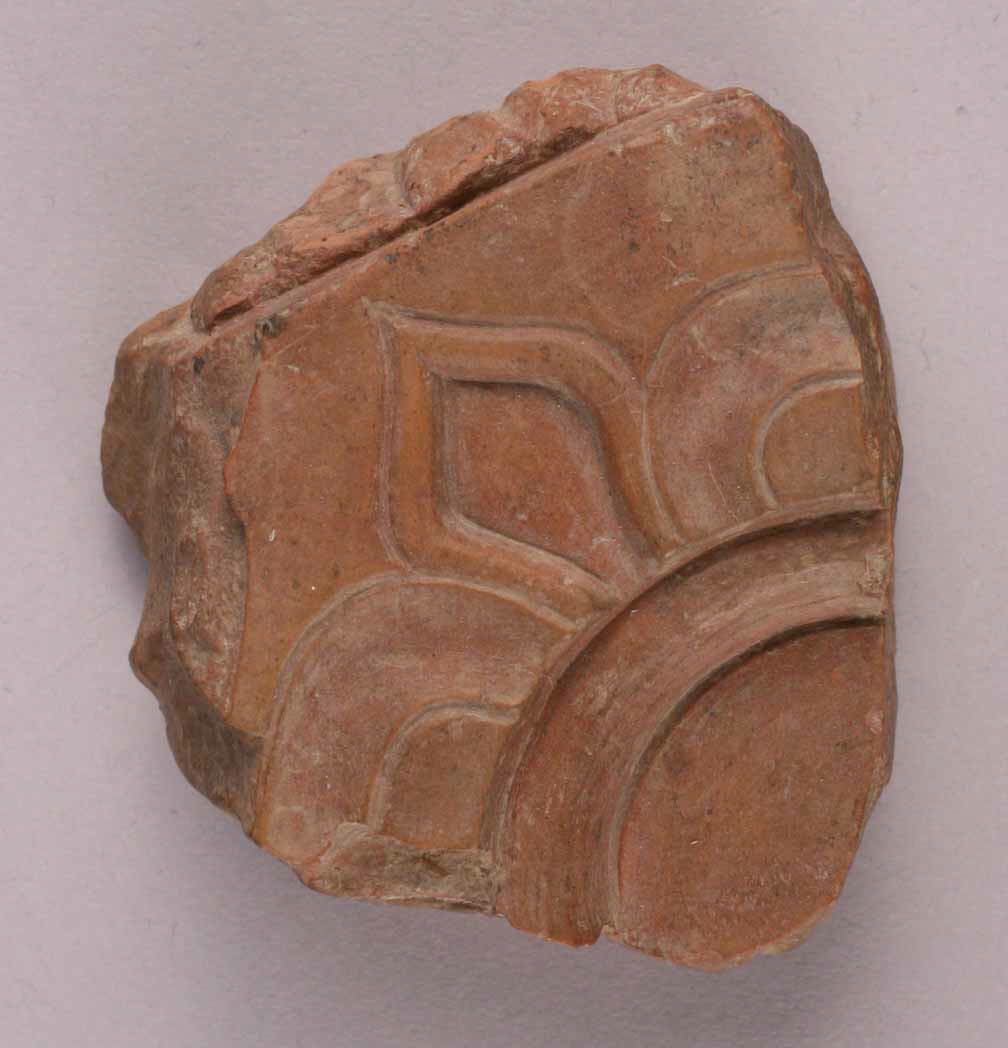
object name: mold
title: Mold for Making Ceramics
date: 867-933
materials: clay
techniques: molding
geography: iran